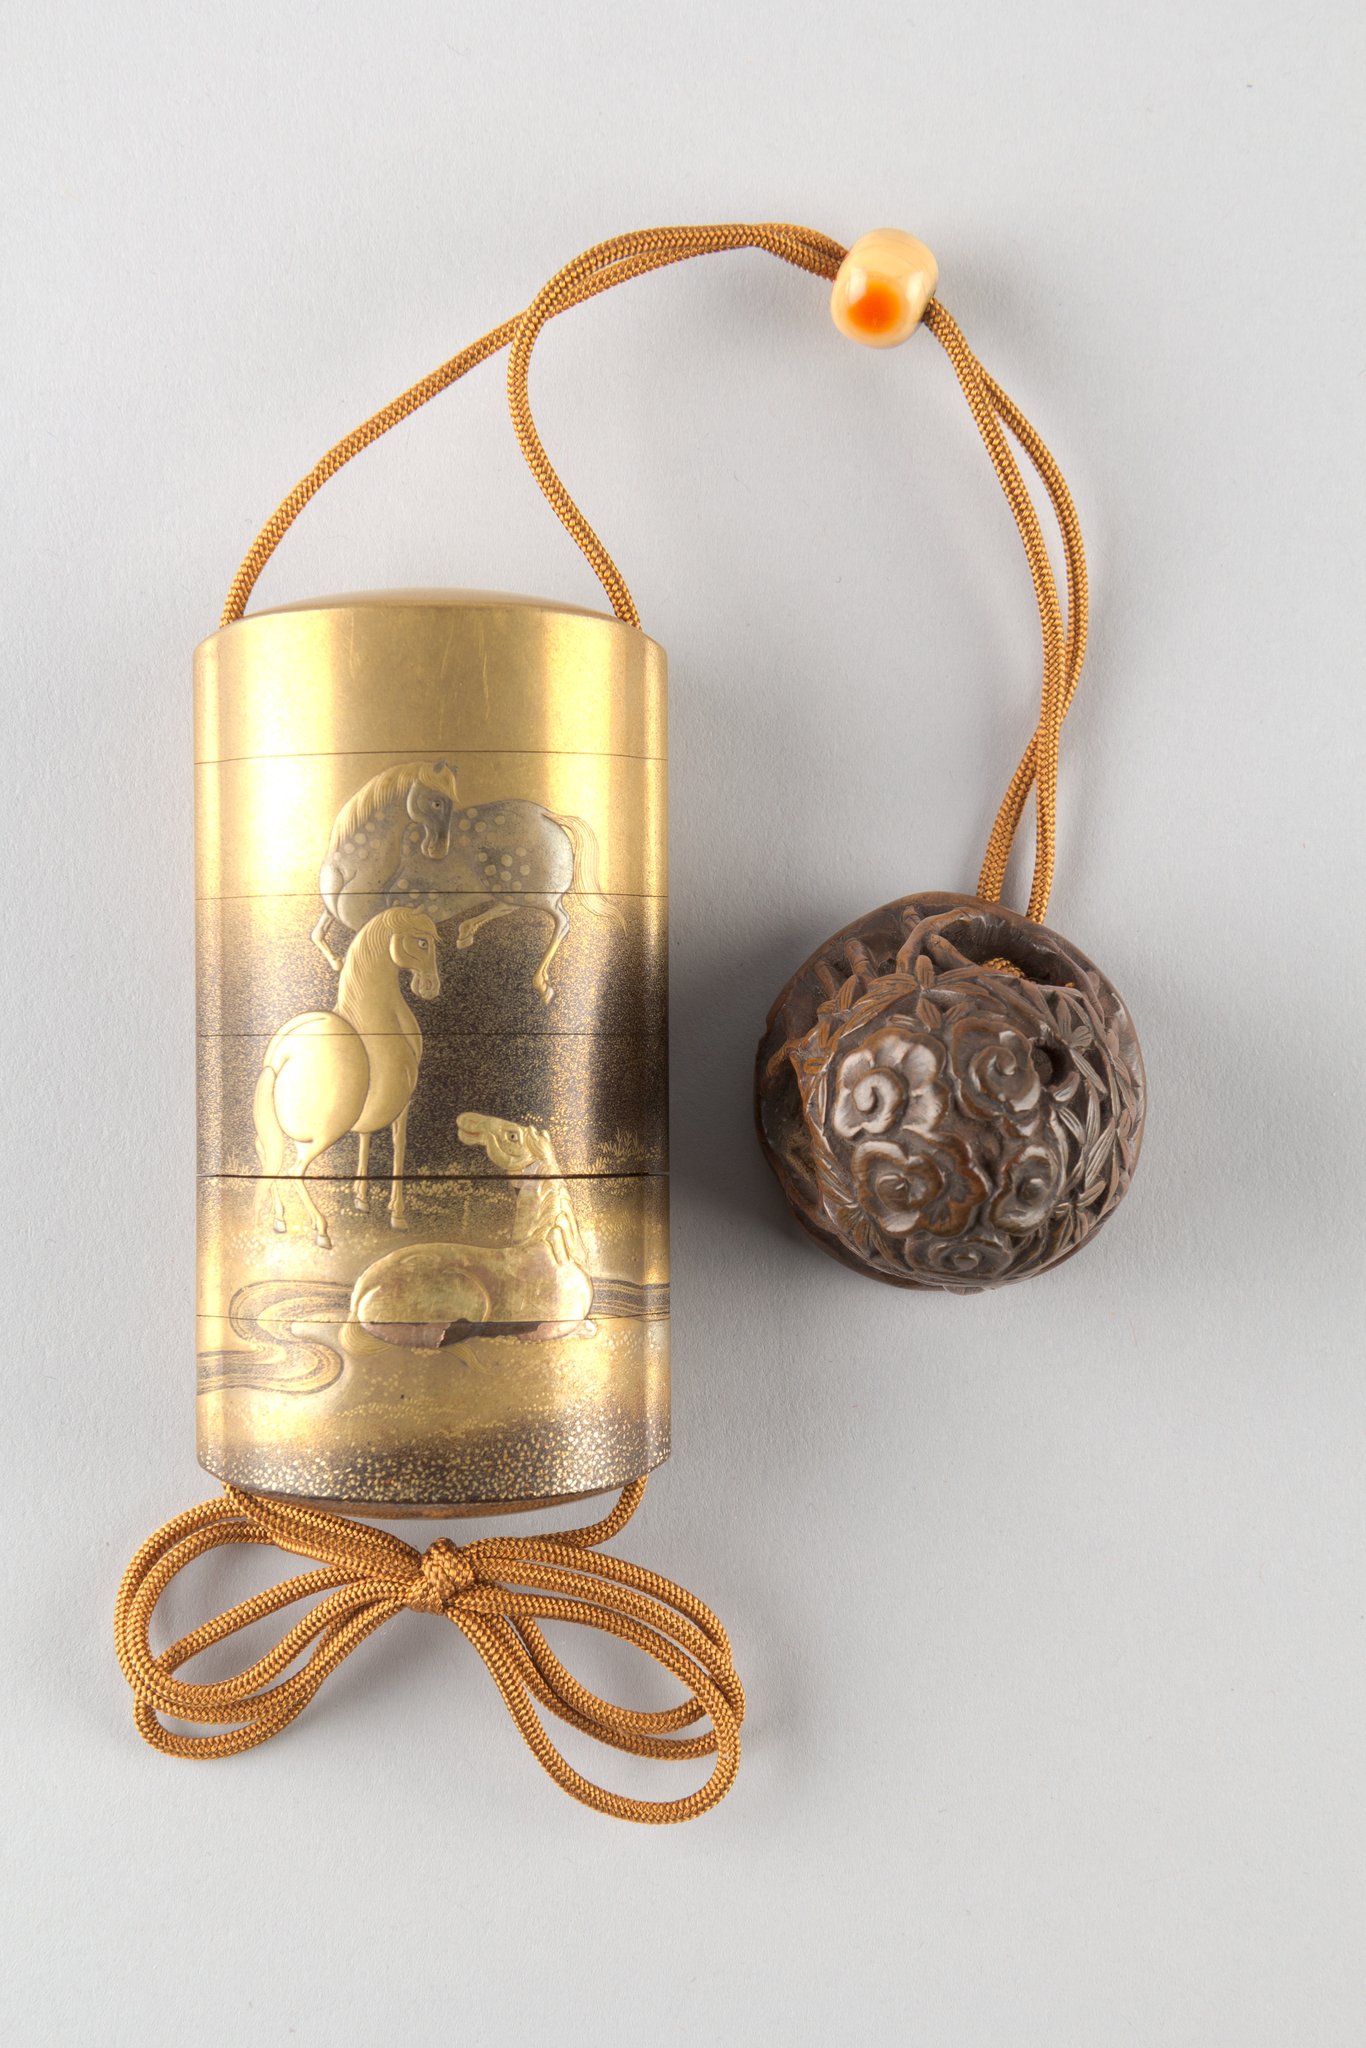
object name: inrō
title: Inrō with Seven Horses by a River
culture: japanese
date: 1767-1833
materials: bamboo, foil, gold, ivory, silver, wood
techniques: carving, hiramakie, lacquer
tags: horses